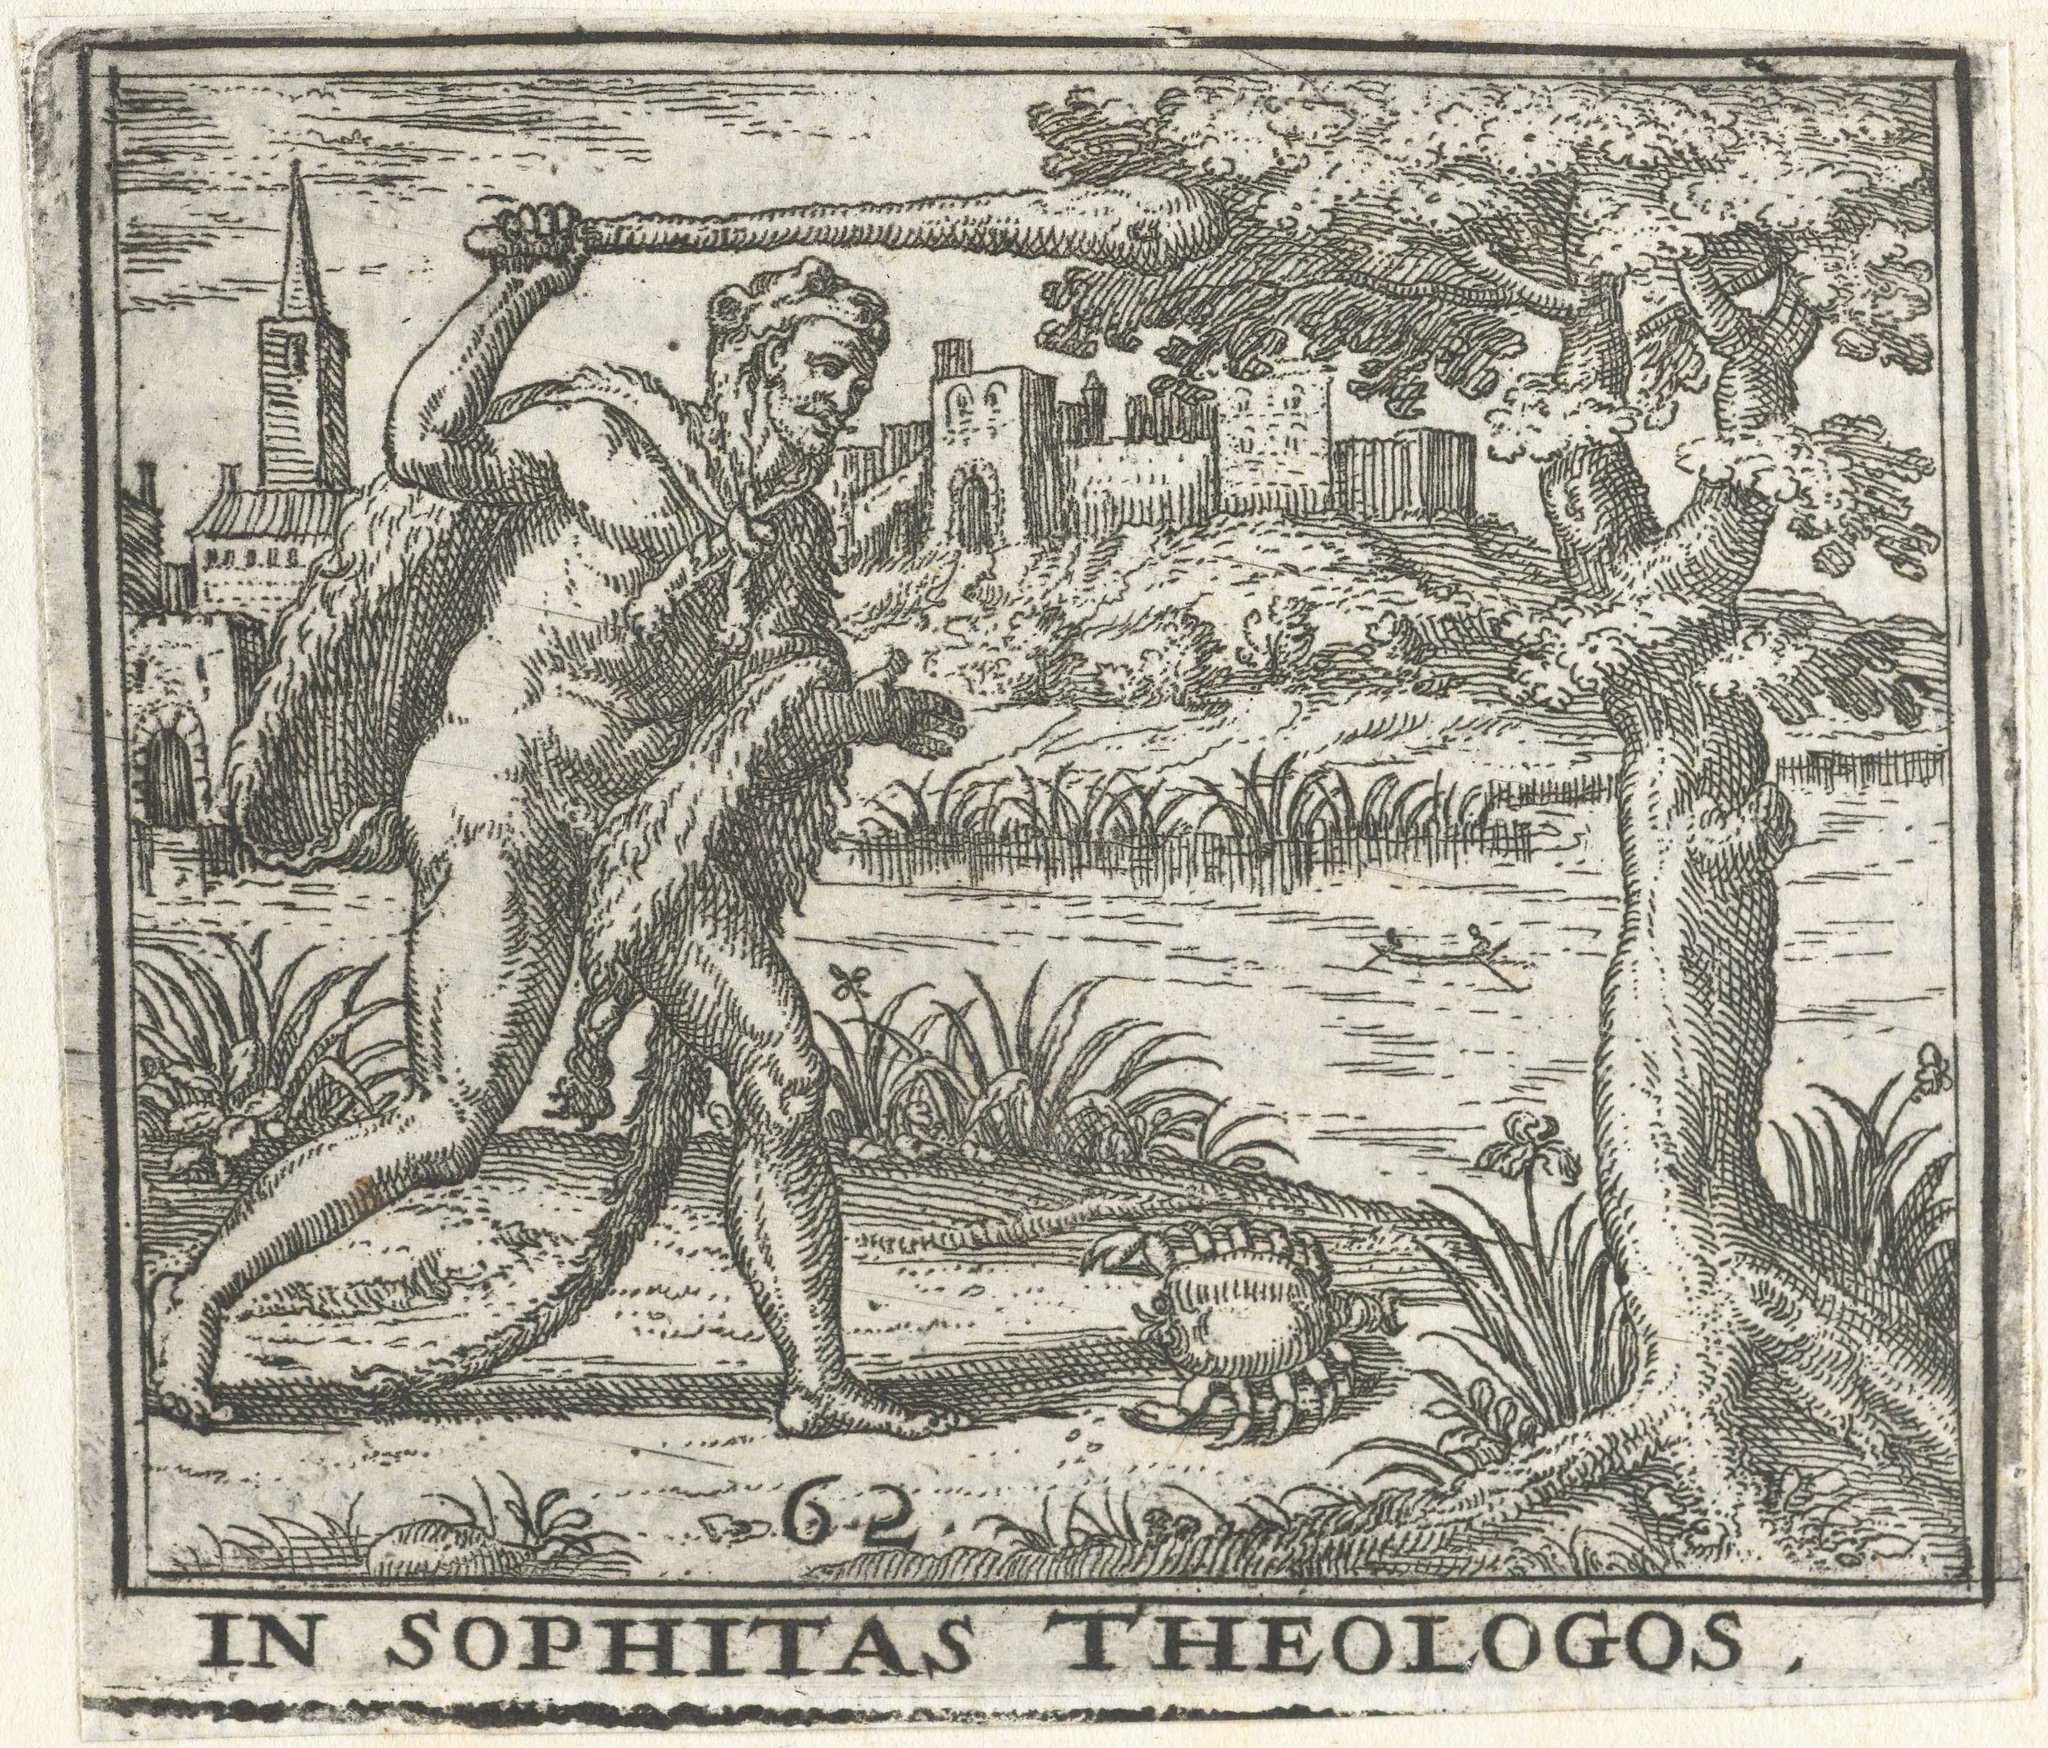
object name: cognizance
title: IN SOPHITAS THEOLOGOS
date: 1596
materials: paper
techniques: engraving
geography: frankfurt am main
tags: the hydra is killed by hercules assisted by iolaus, who sears the roots of the severed heads with burning brands; an enormous crab nips hercules' foot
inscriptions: collector's mark: Lugt 240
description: Hercules wordt door een reusachtige krab aangevallen die probeert in zijn voet te bijten. Volgens het verhaal is de krab gestuurd door Juno die Hercules wil tegenhouden in zijn strijd tegen de hydra van Lerna.